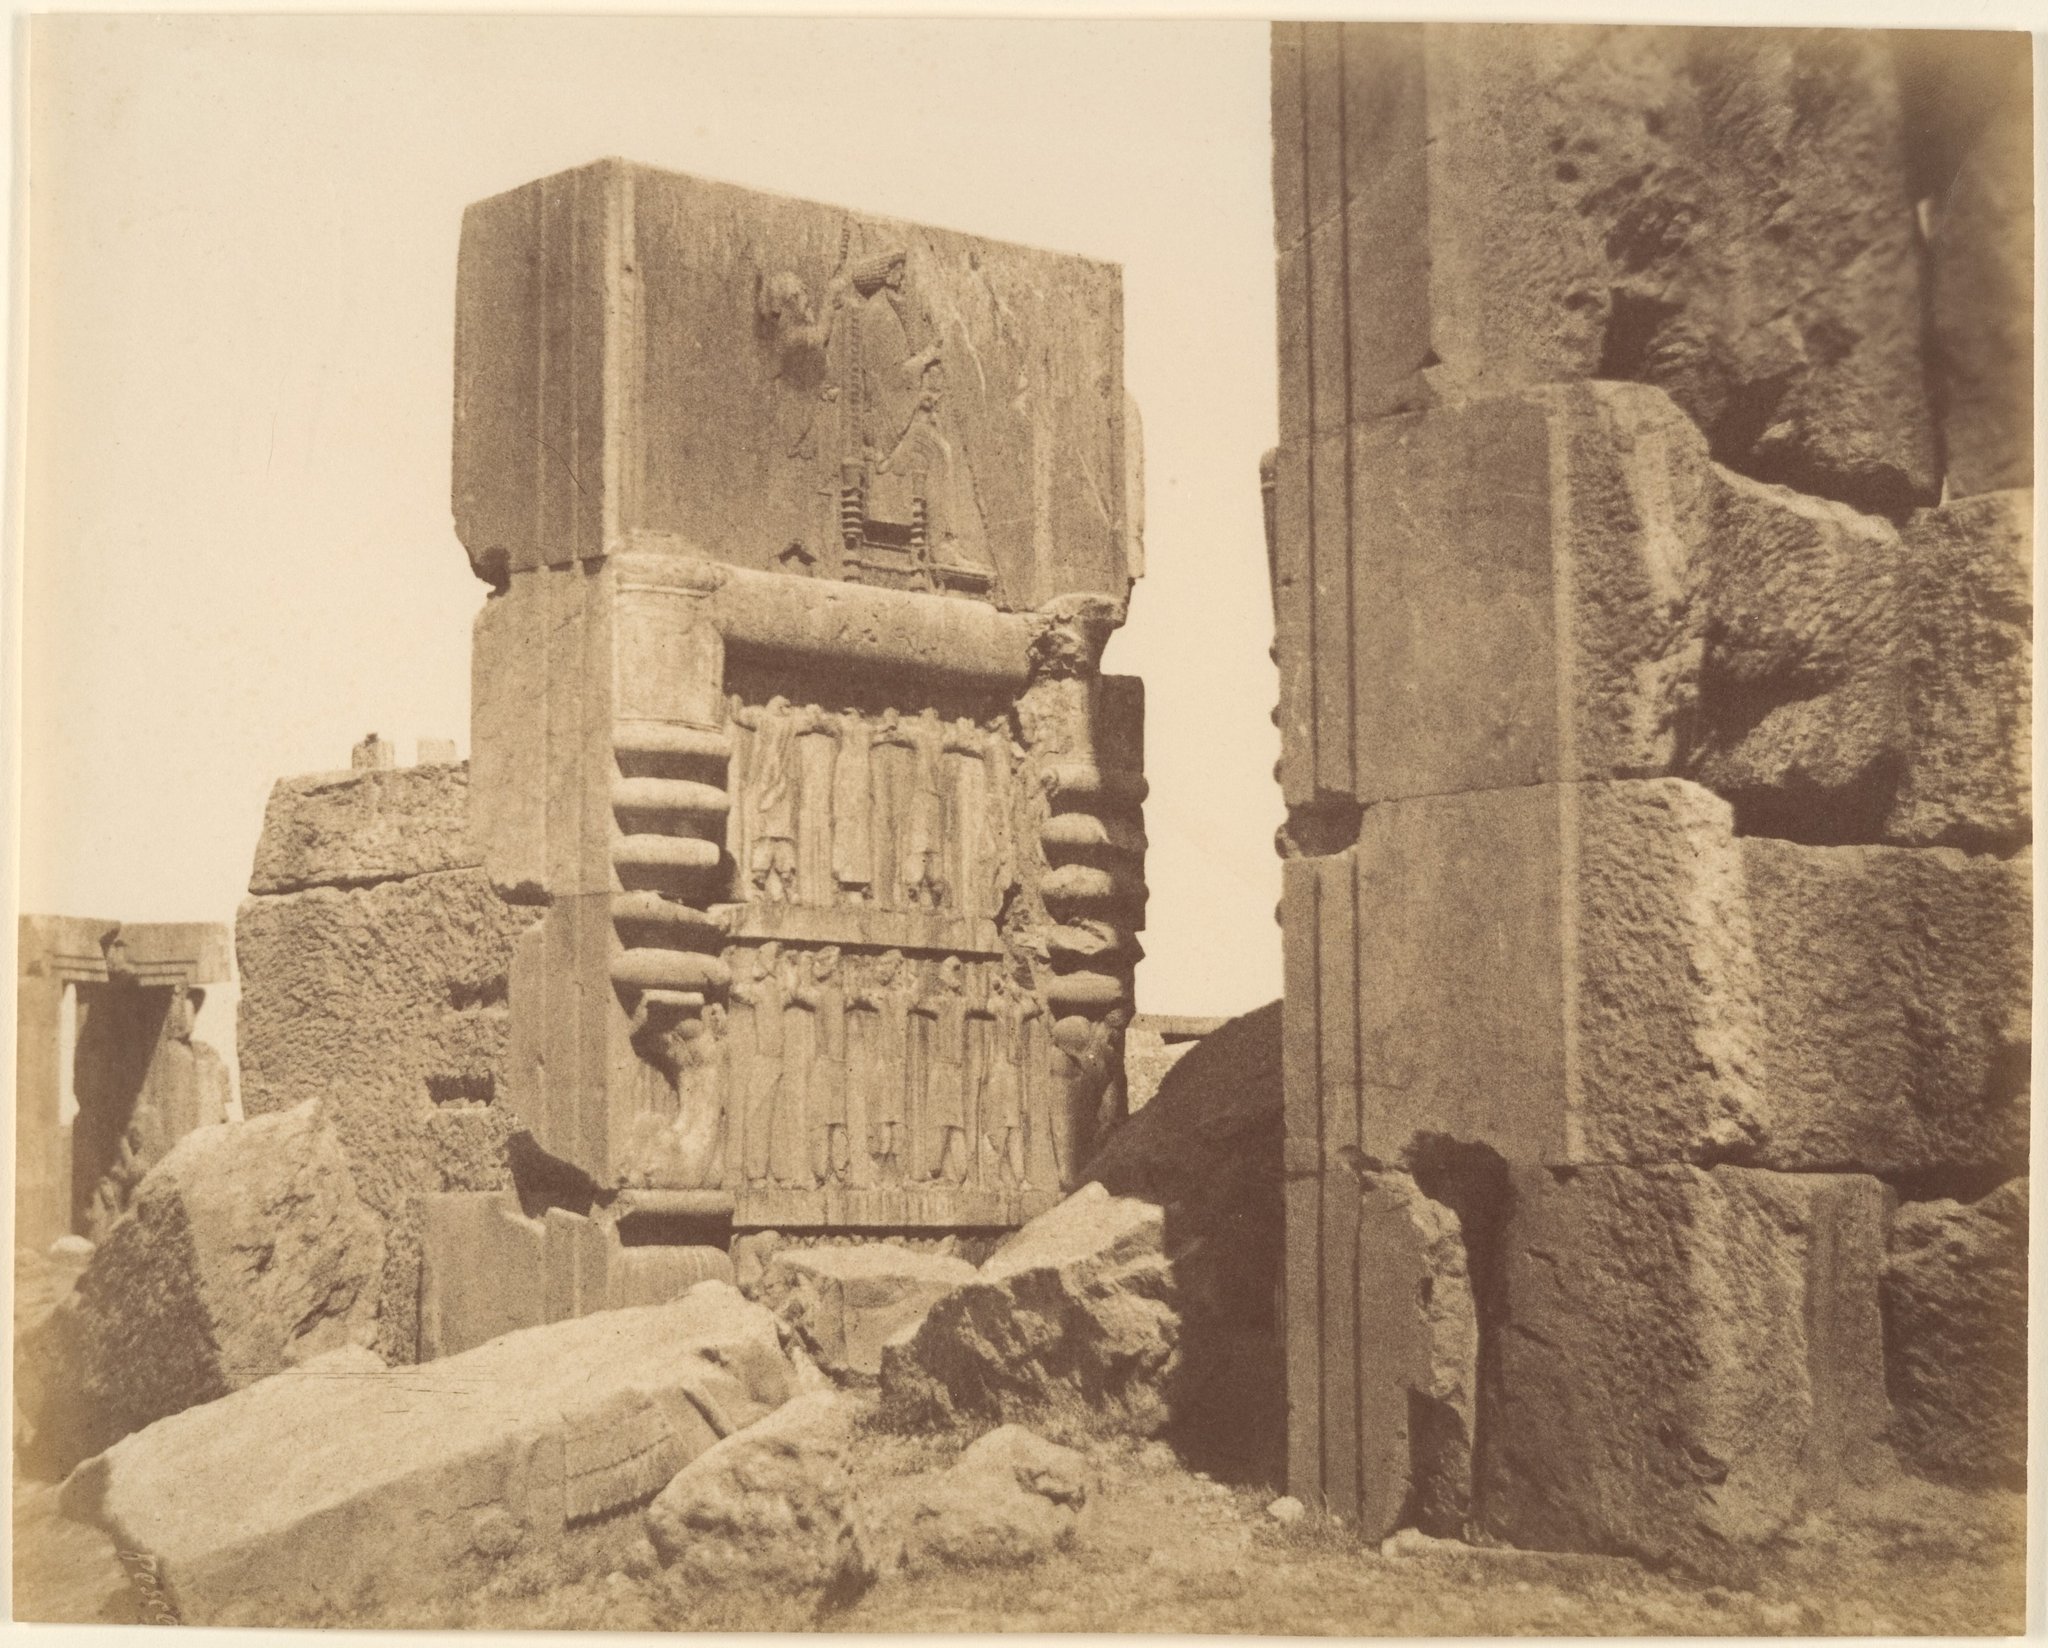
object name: photograph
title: (13) [Persepolis]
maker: luigi pesce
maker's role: artist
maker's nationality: italian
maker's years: 1818-1891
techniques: albumen silver print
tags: architecture,ruins